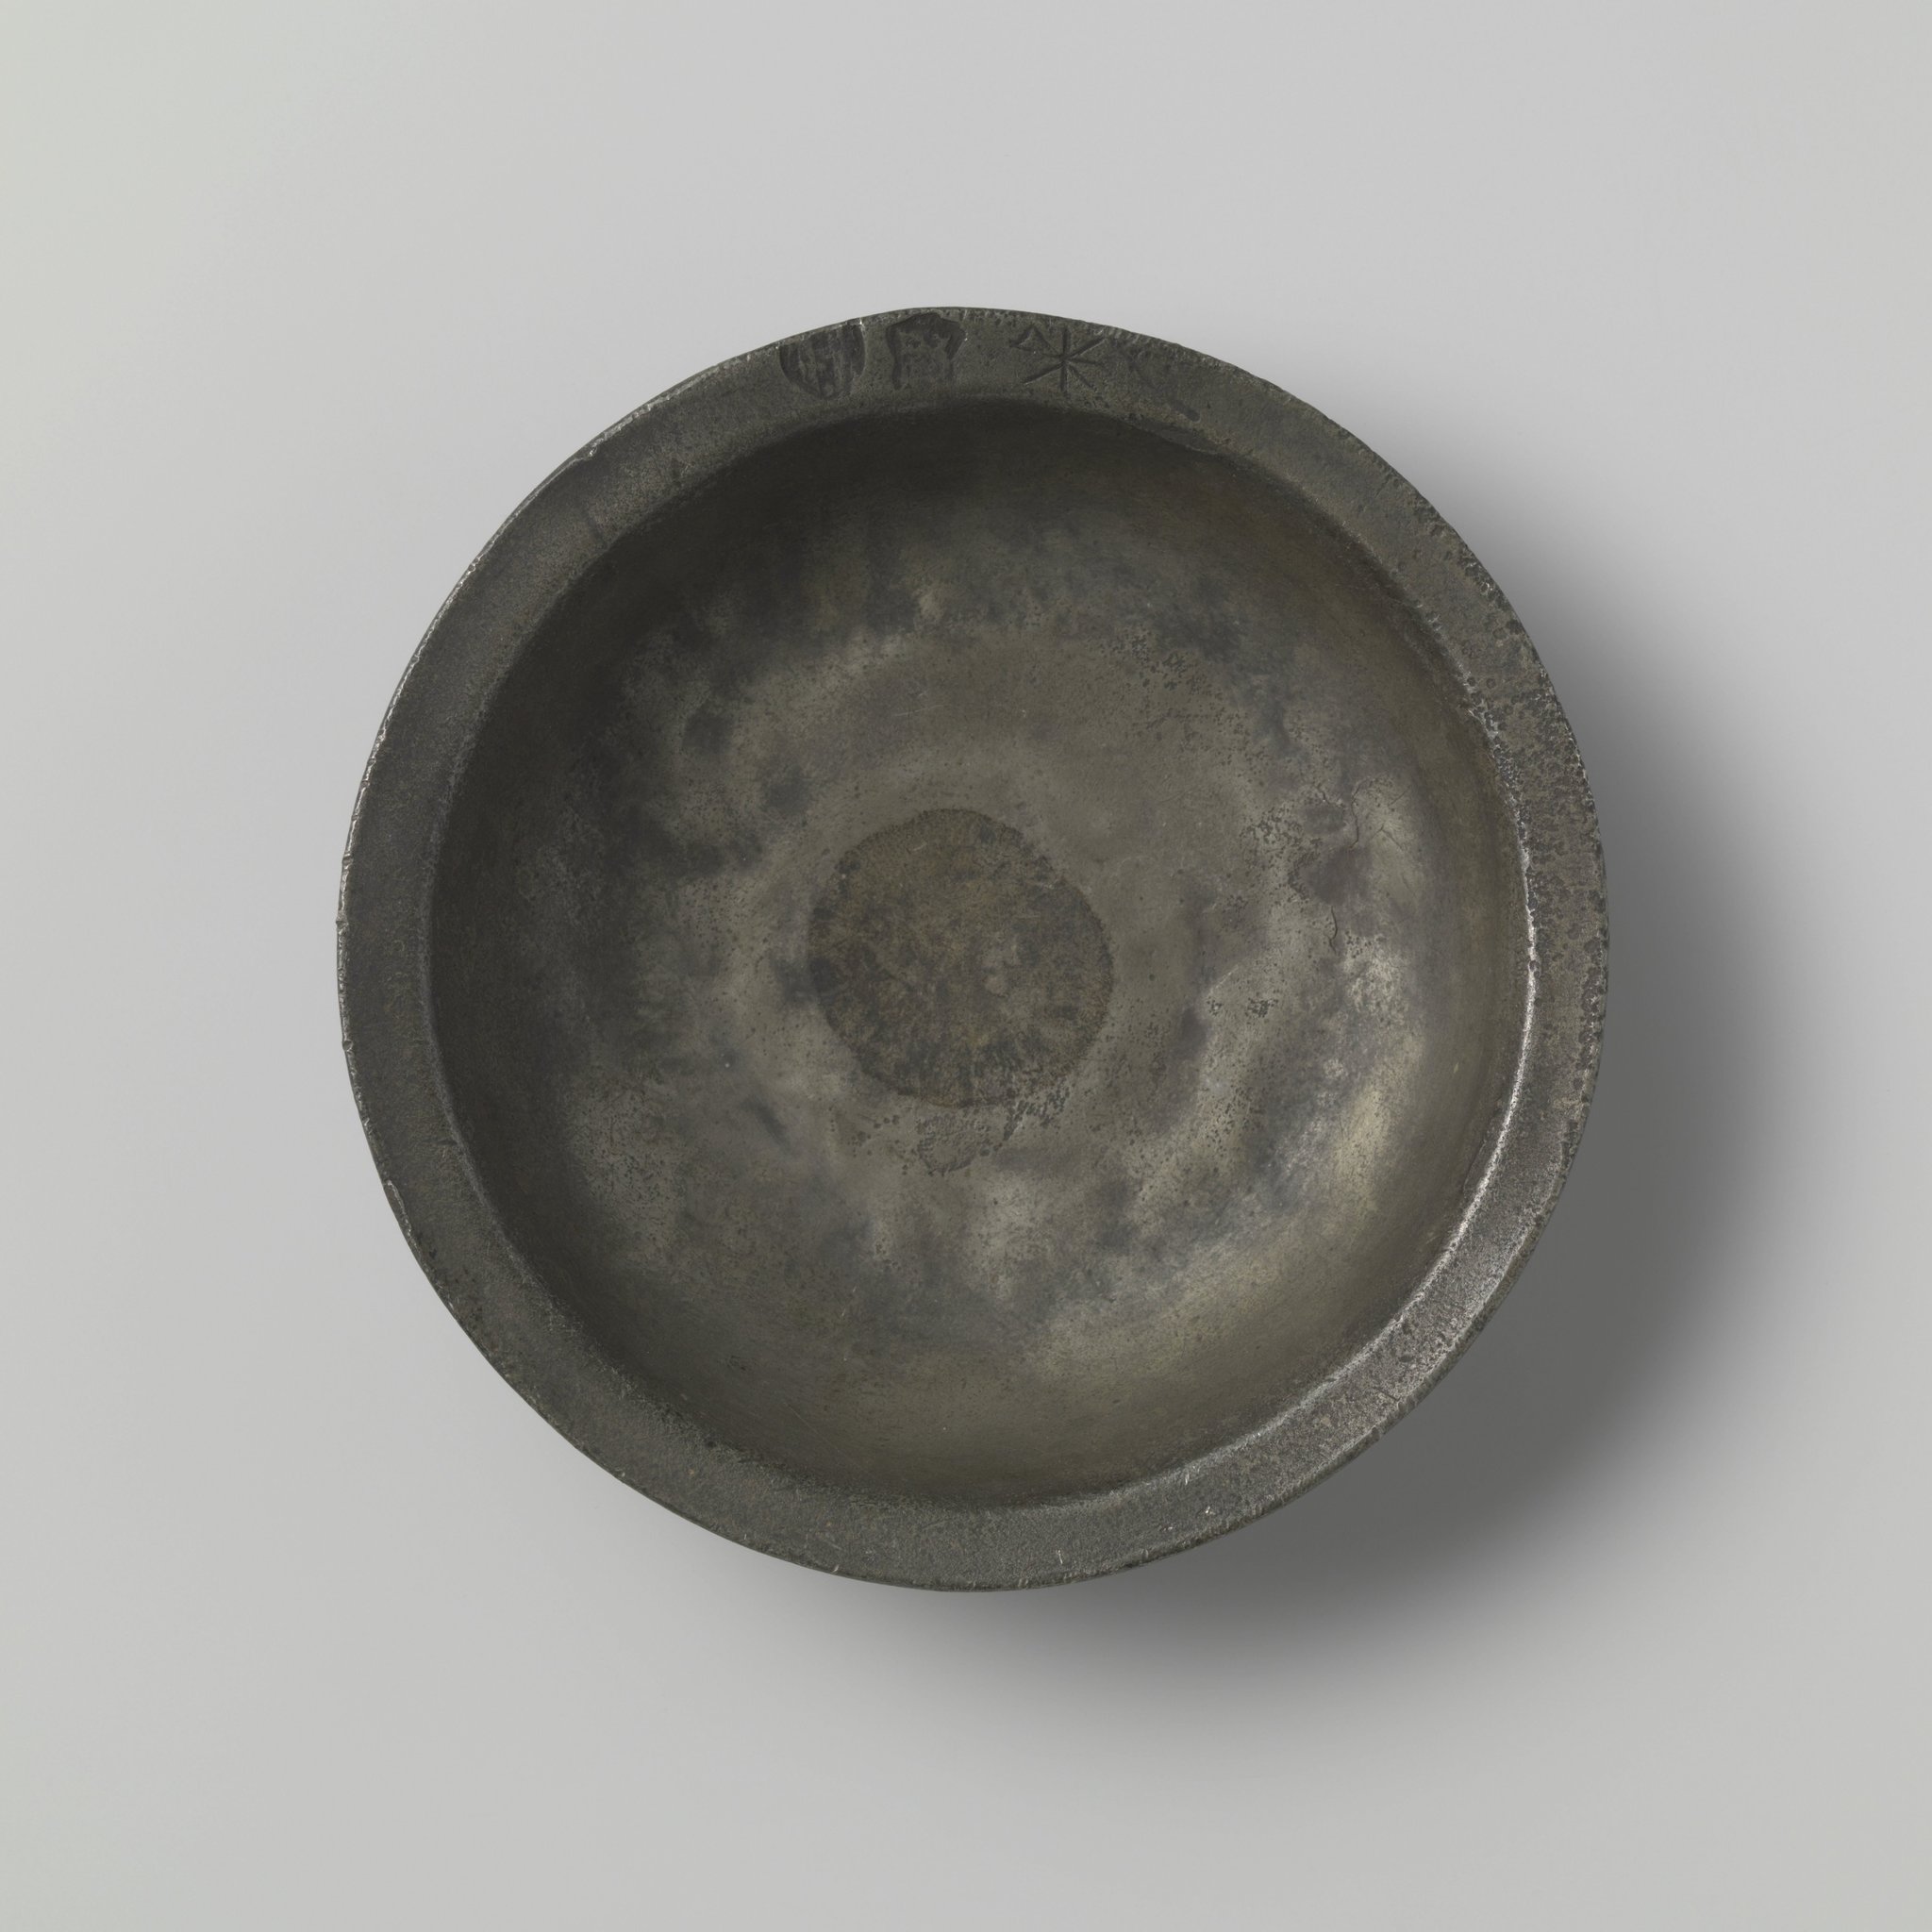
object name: bowl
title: Kom van tin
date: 1400-1950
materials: tin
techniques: casting, turning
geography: rotterdam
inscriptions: quality mark, house mark, maker's mark, house mark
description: Komvormig schoteltje met smalle rand. Gemerkt op de rand met twee schildjes waarin het stadswapen van Rotterdam en een gekroond meesterteken; tevens een geometrische figuur. Gevonden in de bodem van Rotterdam.